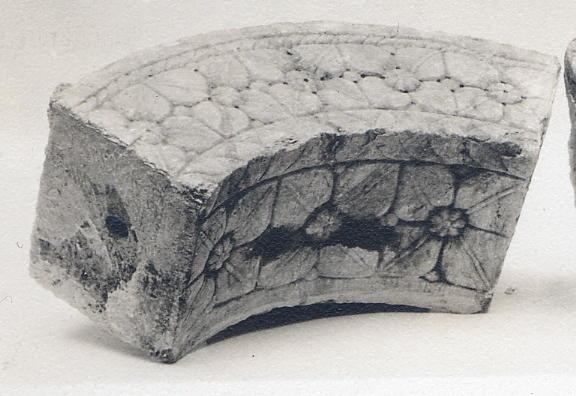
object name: voussoir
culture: catalan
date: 1130-1140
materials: marble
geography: france